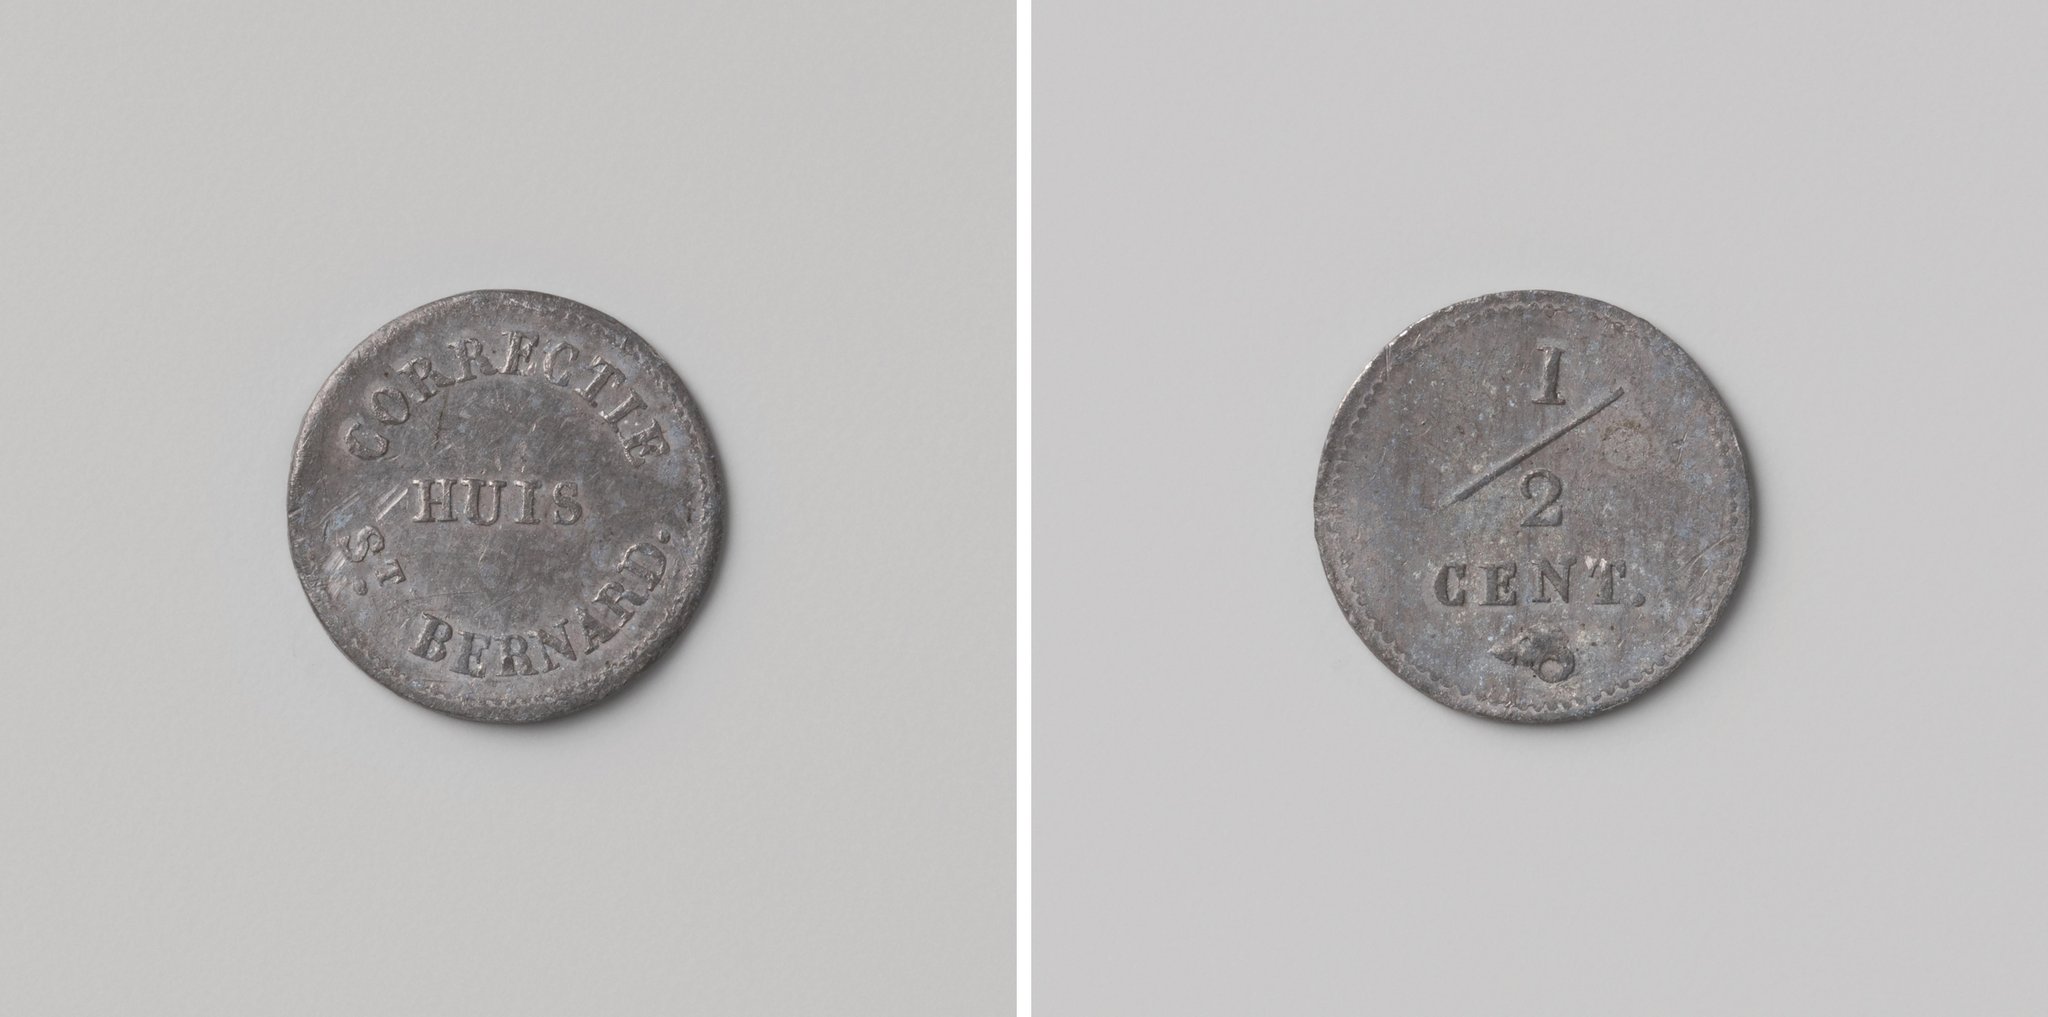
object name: monetary token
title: Correctiehuis Sint Bernhard te Hemiksem, huismunt ter waarde van een halve cent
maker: joseph pierre braemt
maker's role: print maker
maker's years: 1796-1864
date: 1826-1833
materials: zinc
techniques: striking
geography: brussels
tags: ghent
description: Zinken betaalpenning. Voorzijde: opschrift binnen omschrift. Keerzijde: waardeaanduiding